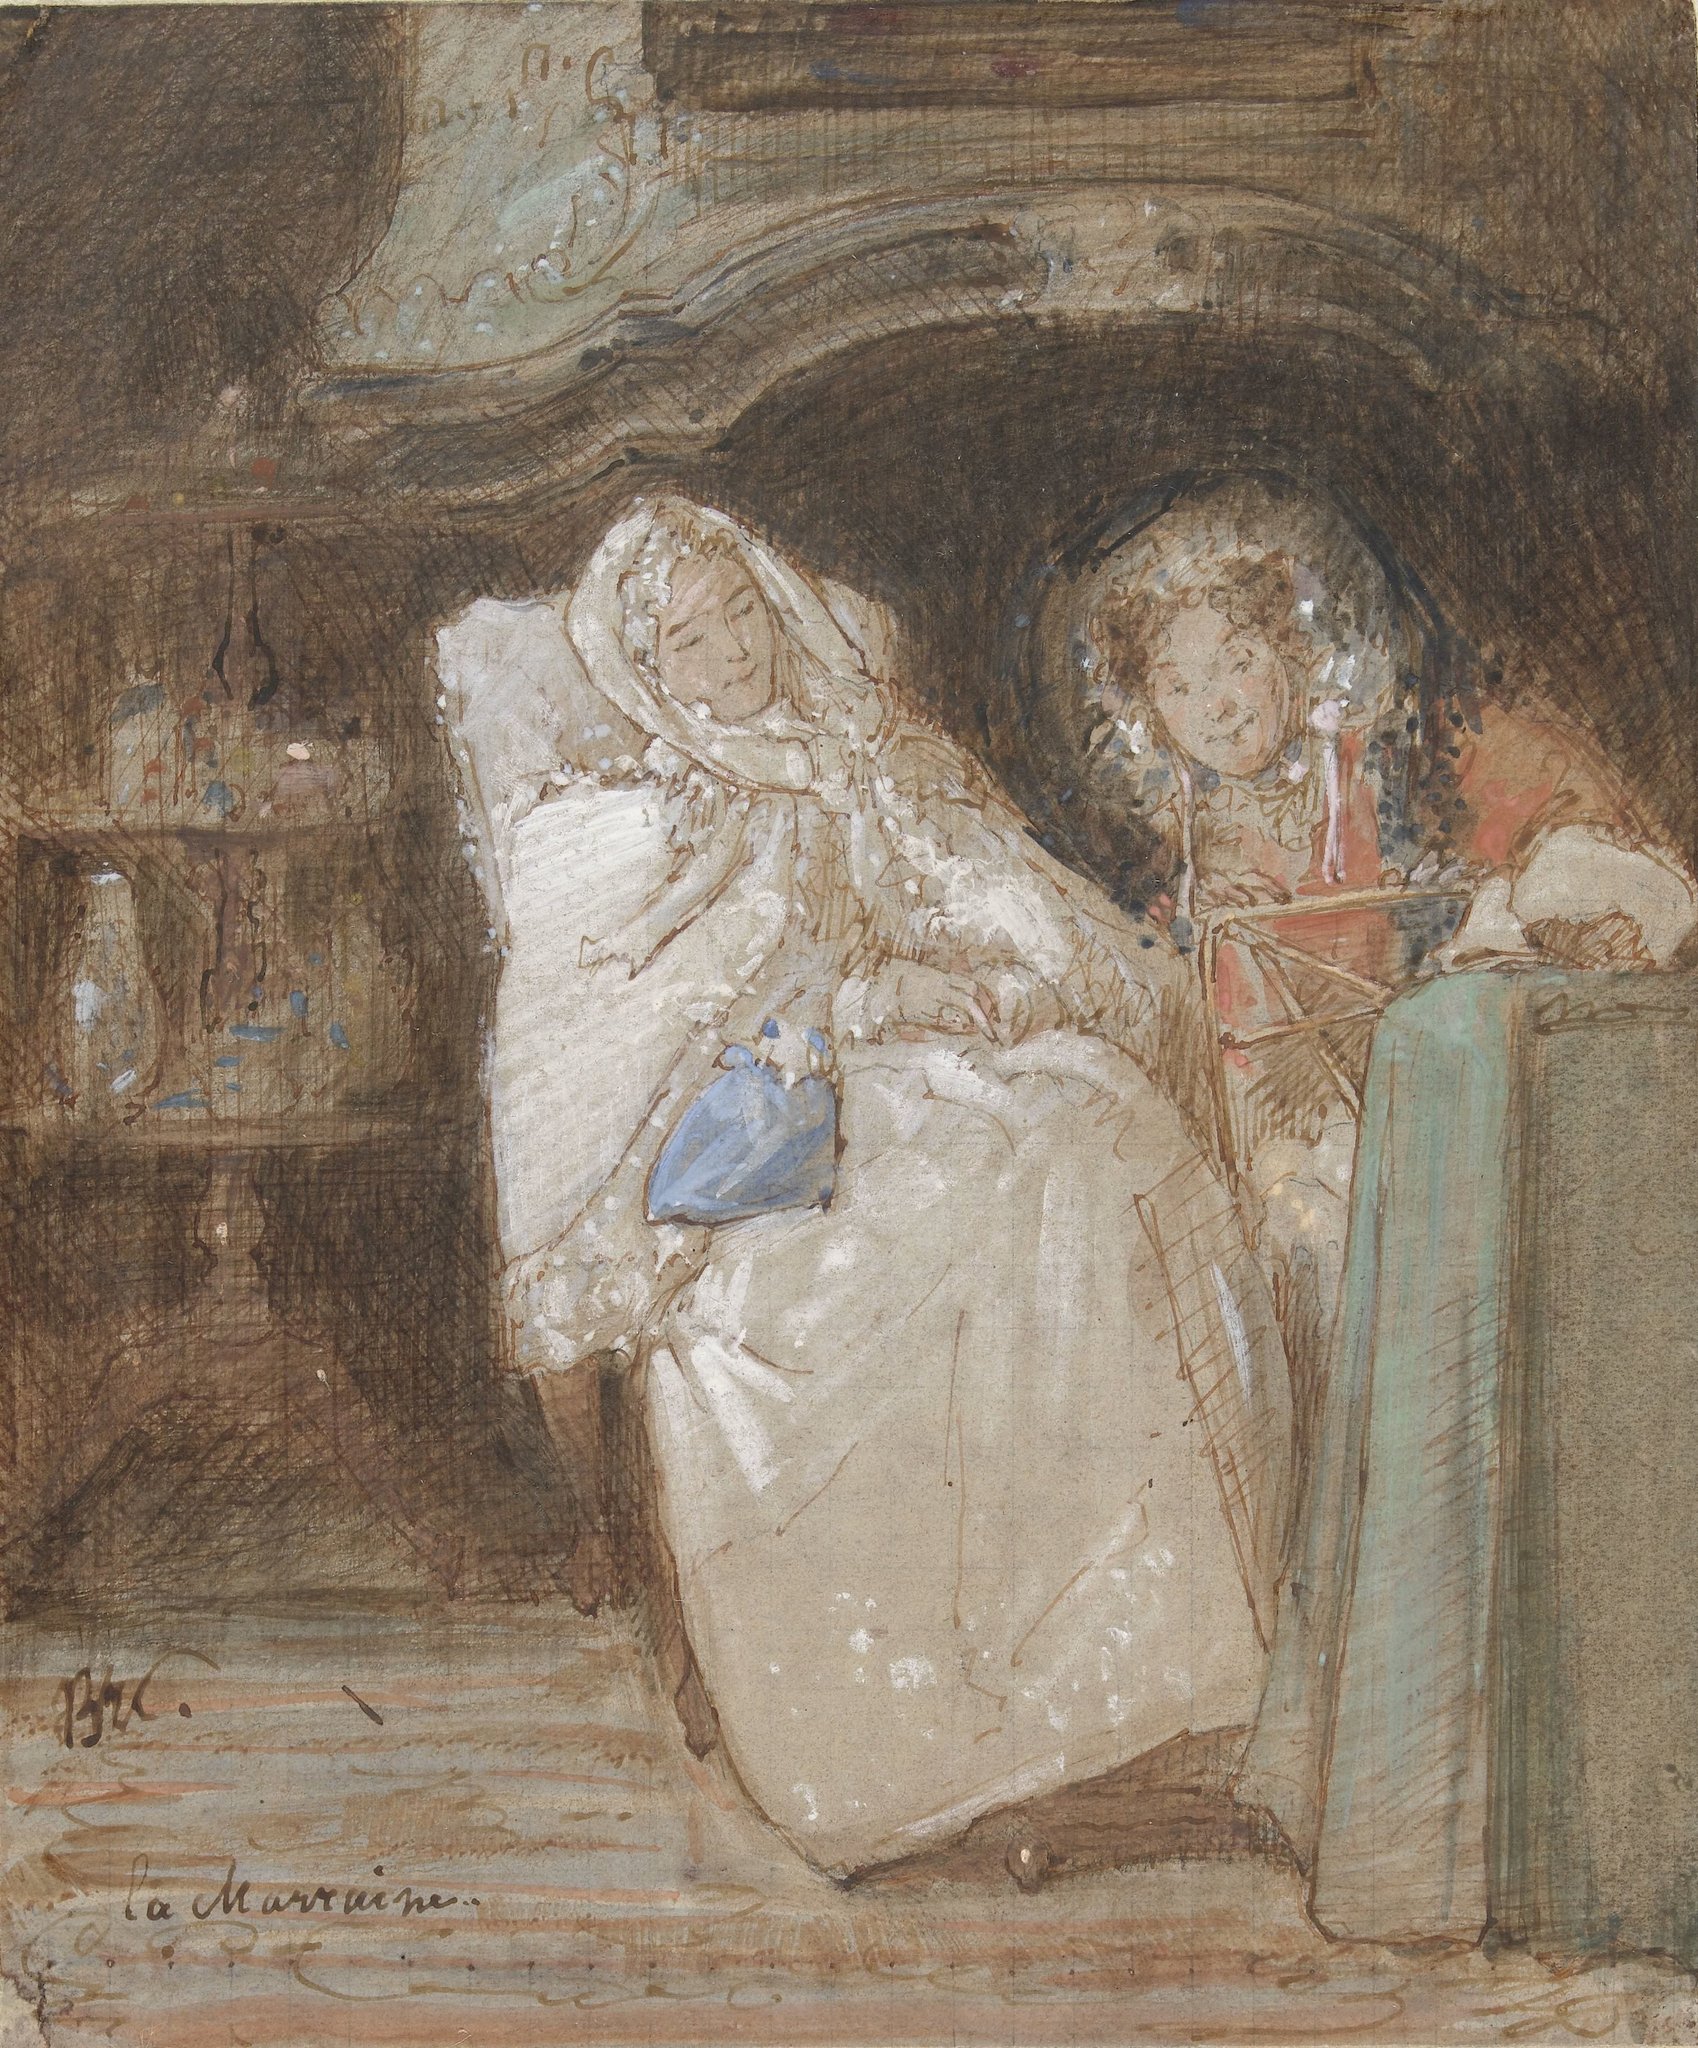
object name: drawing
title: De peettante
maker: alexander hugo bakker korff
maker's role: draughtsman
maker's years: 1824-1882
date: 1834-1882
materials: ink, paper, pencil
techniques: brush, pen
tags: mother and baby or young child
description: Moeder en een andere vrouw bij een kind in een wieg.